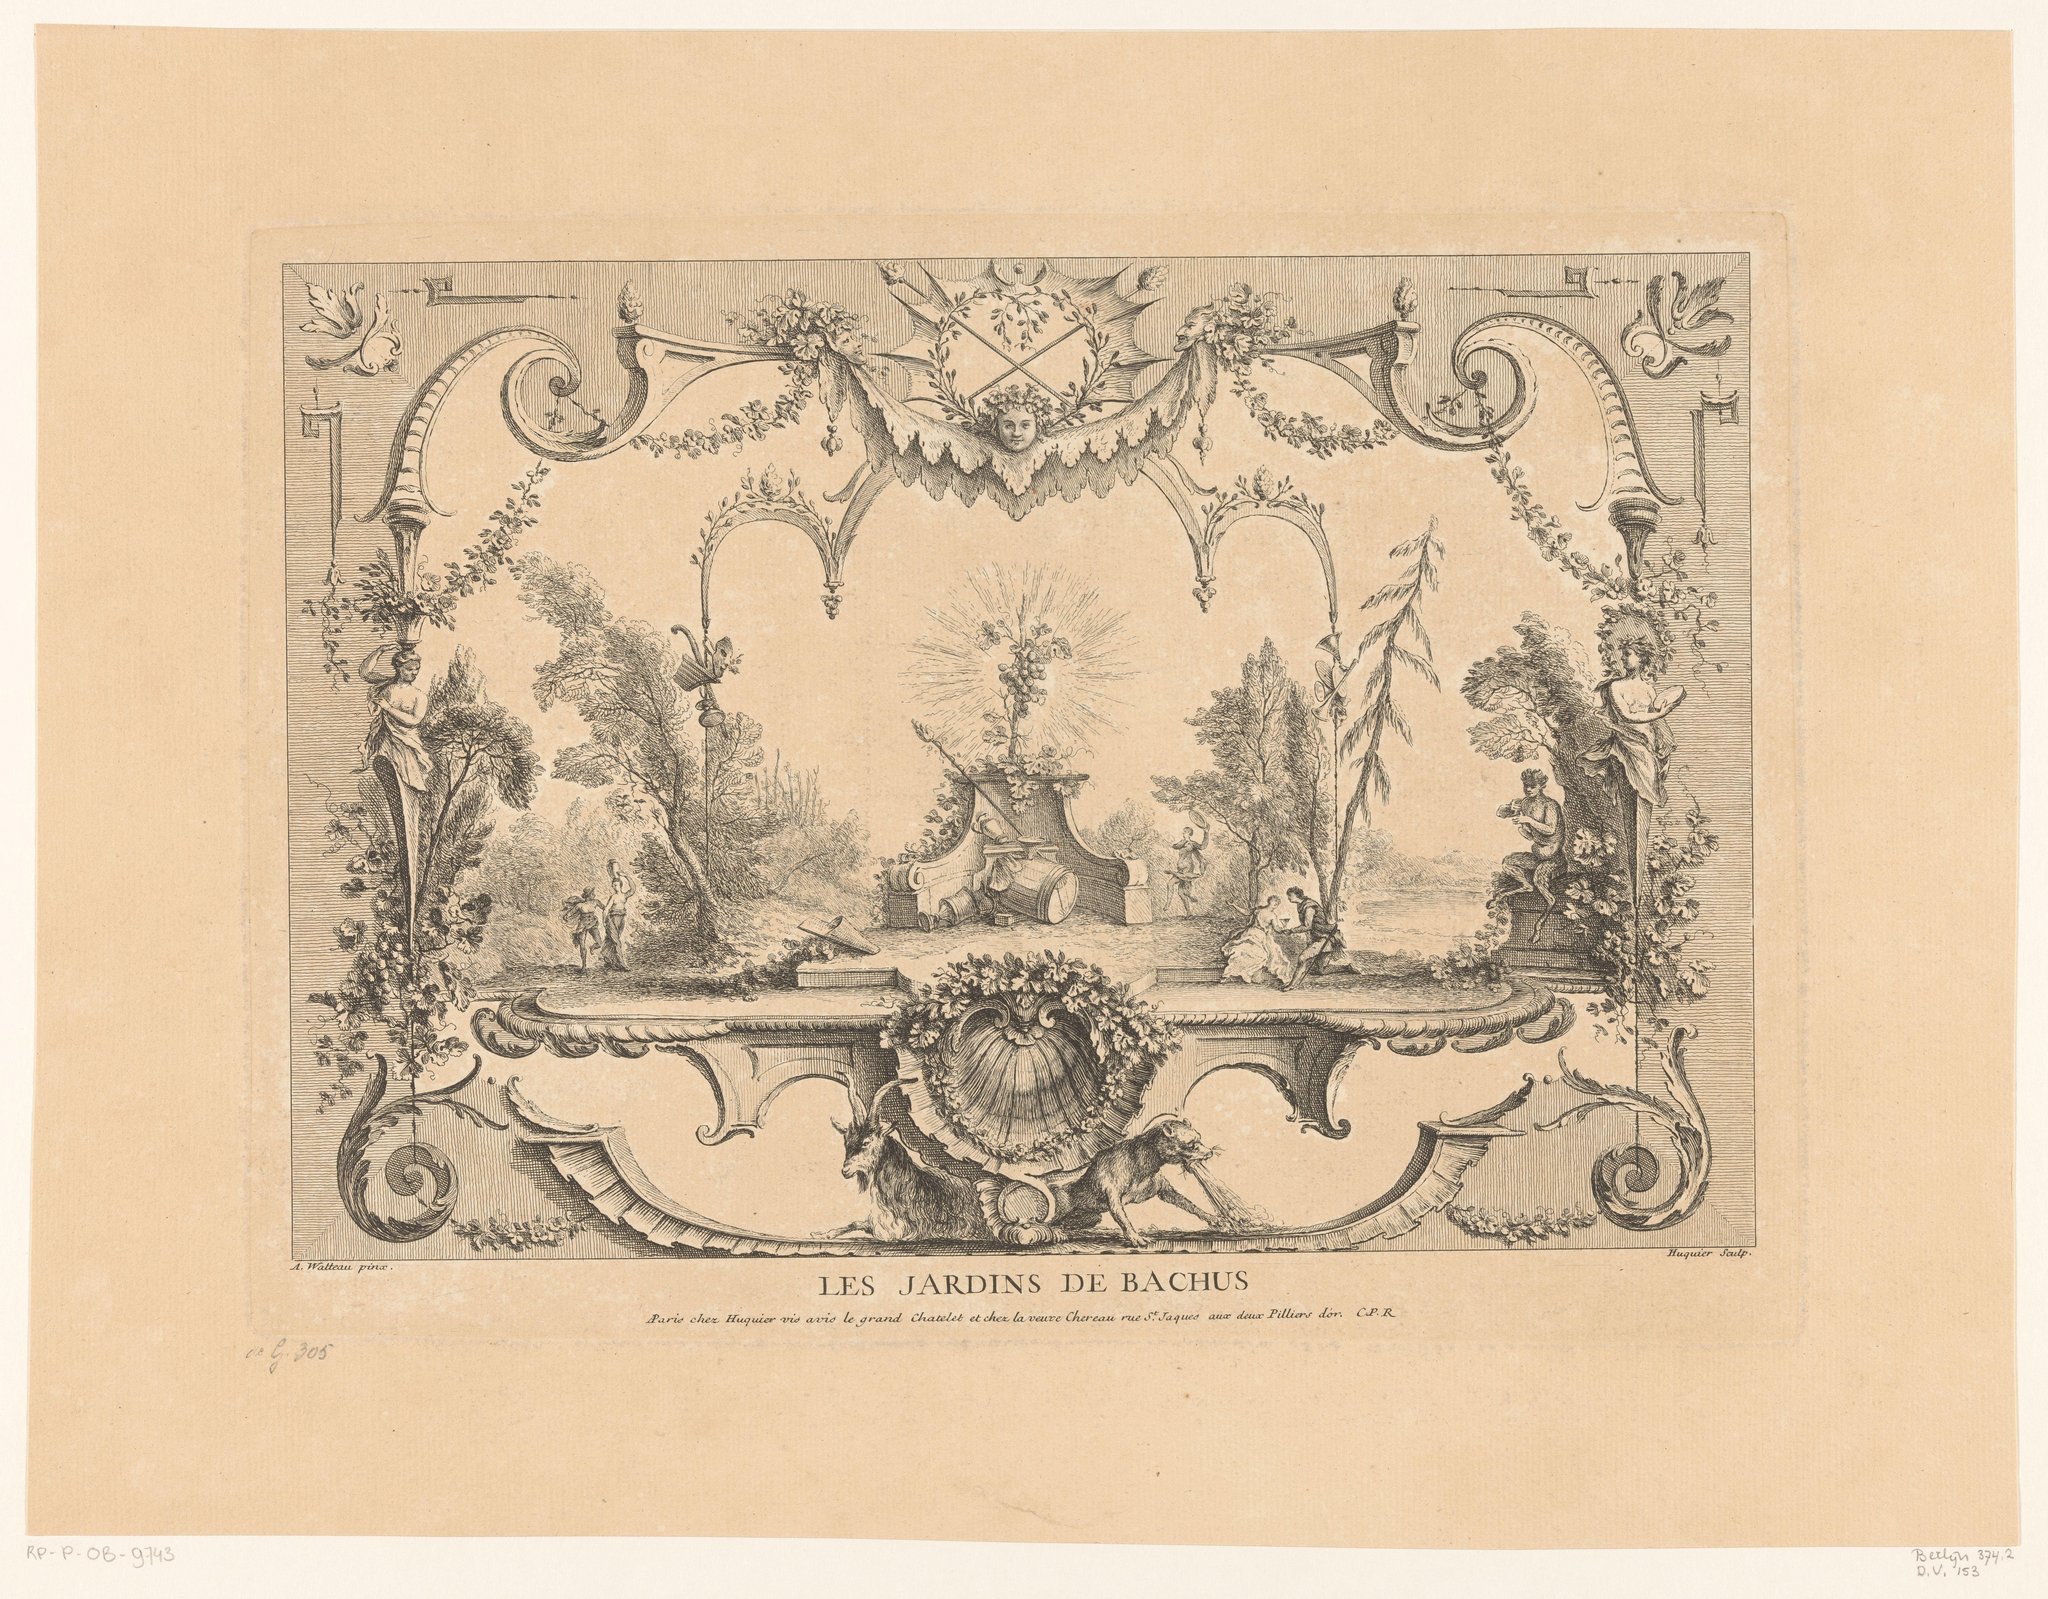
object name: ornament print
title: Tuinen van Bacchus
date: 1729-1737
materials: paper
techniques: etching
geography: paris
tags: (story of) bacchus (dionysus), liber, garden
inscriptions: collector's mark: Lugt 2228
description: Een tuin met twee verliefde koppels, een man met een schaal en rechts een musicerende sater. In het midden staat een wijnstok met stralenkrans op een voetstuk, daarbij liggen een ton, kannen en een thyrsus. Rondom de voorstelling een geornamenteerde omlijsting met guirlandes, maskers, halffiguren, druivenranken, rocailles, een bok en een katachtige.